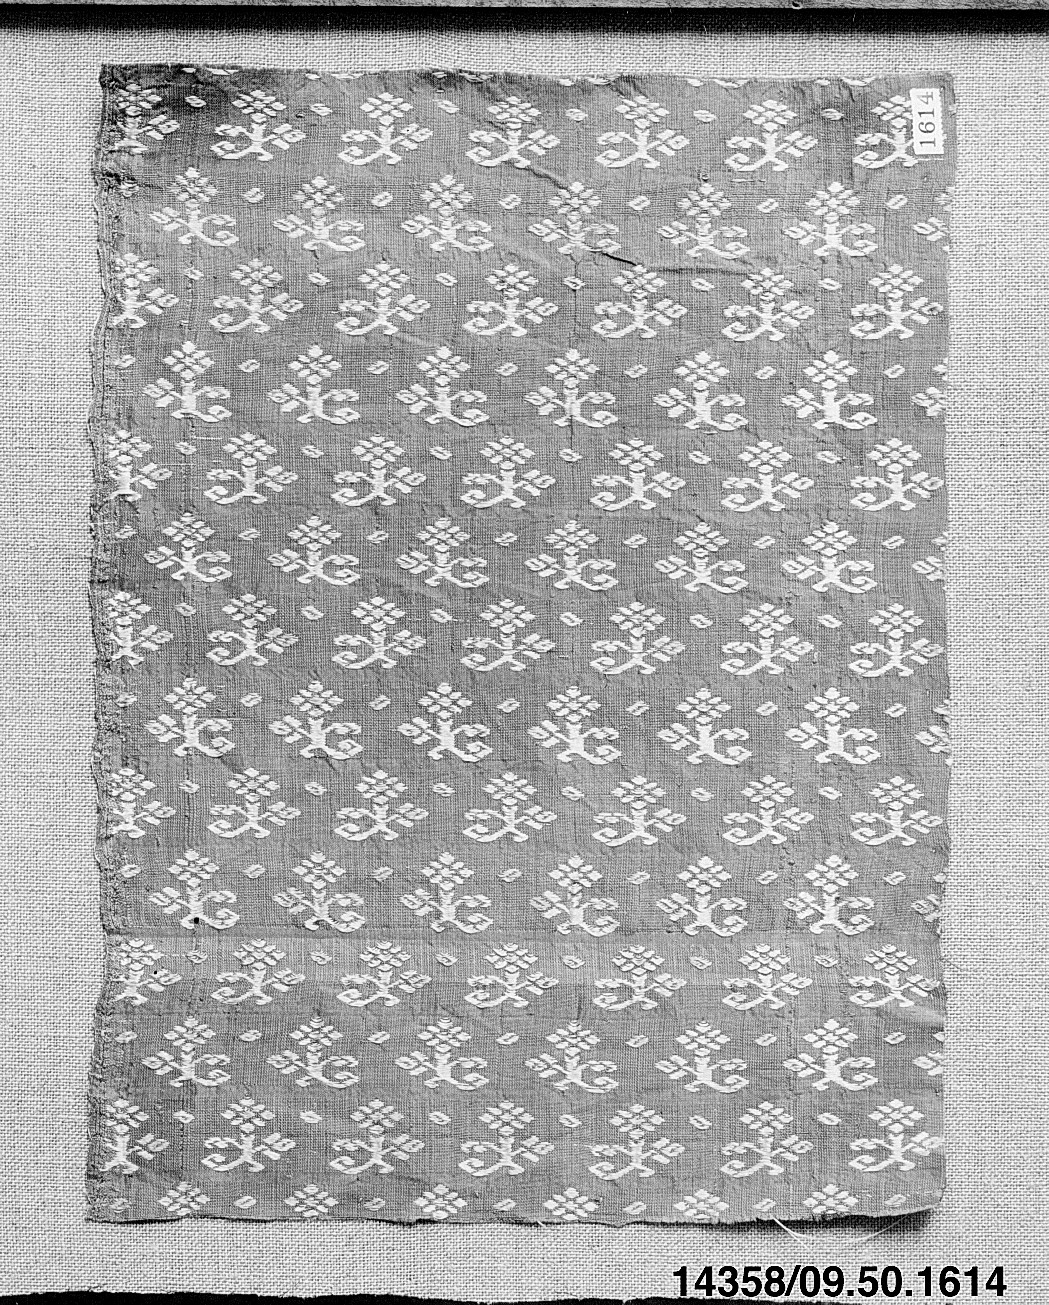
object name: piece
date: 1701-1800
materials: silk